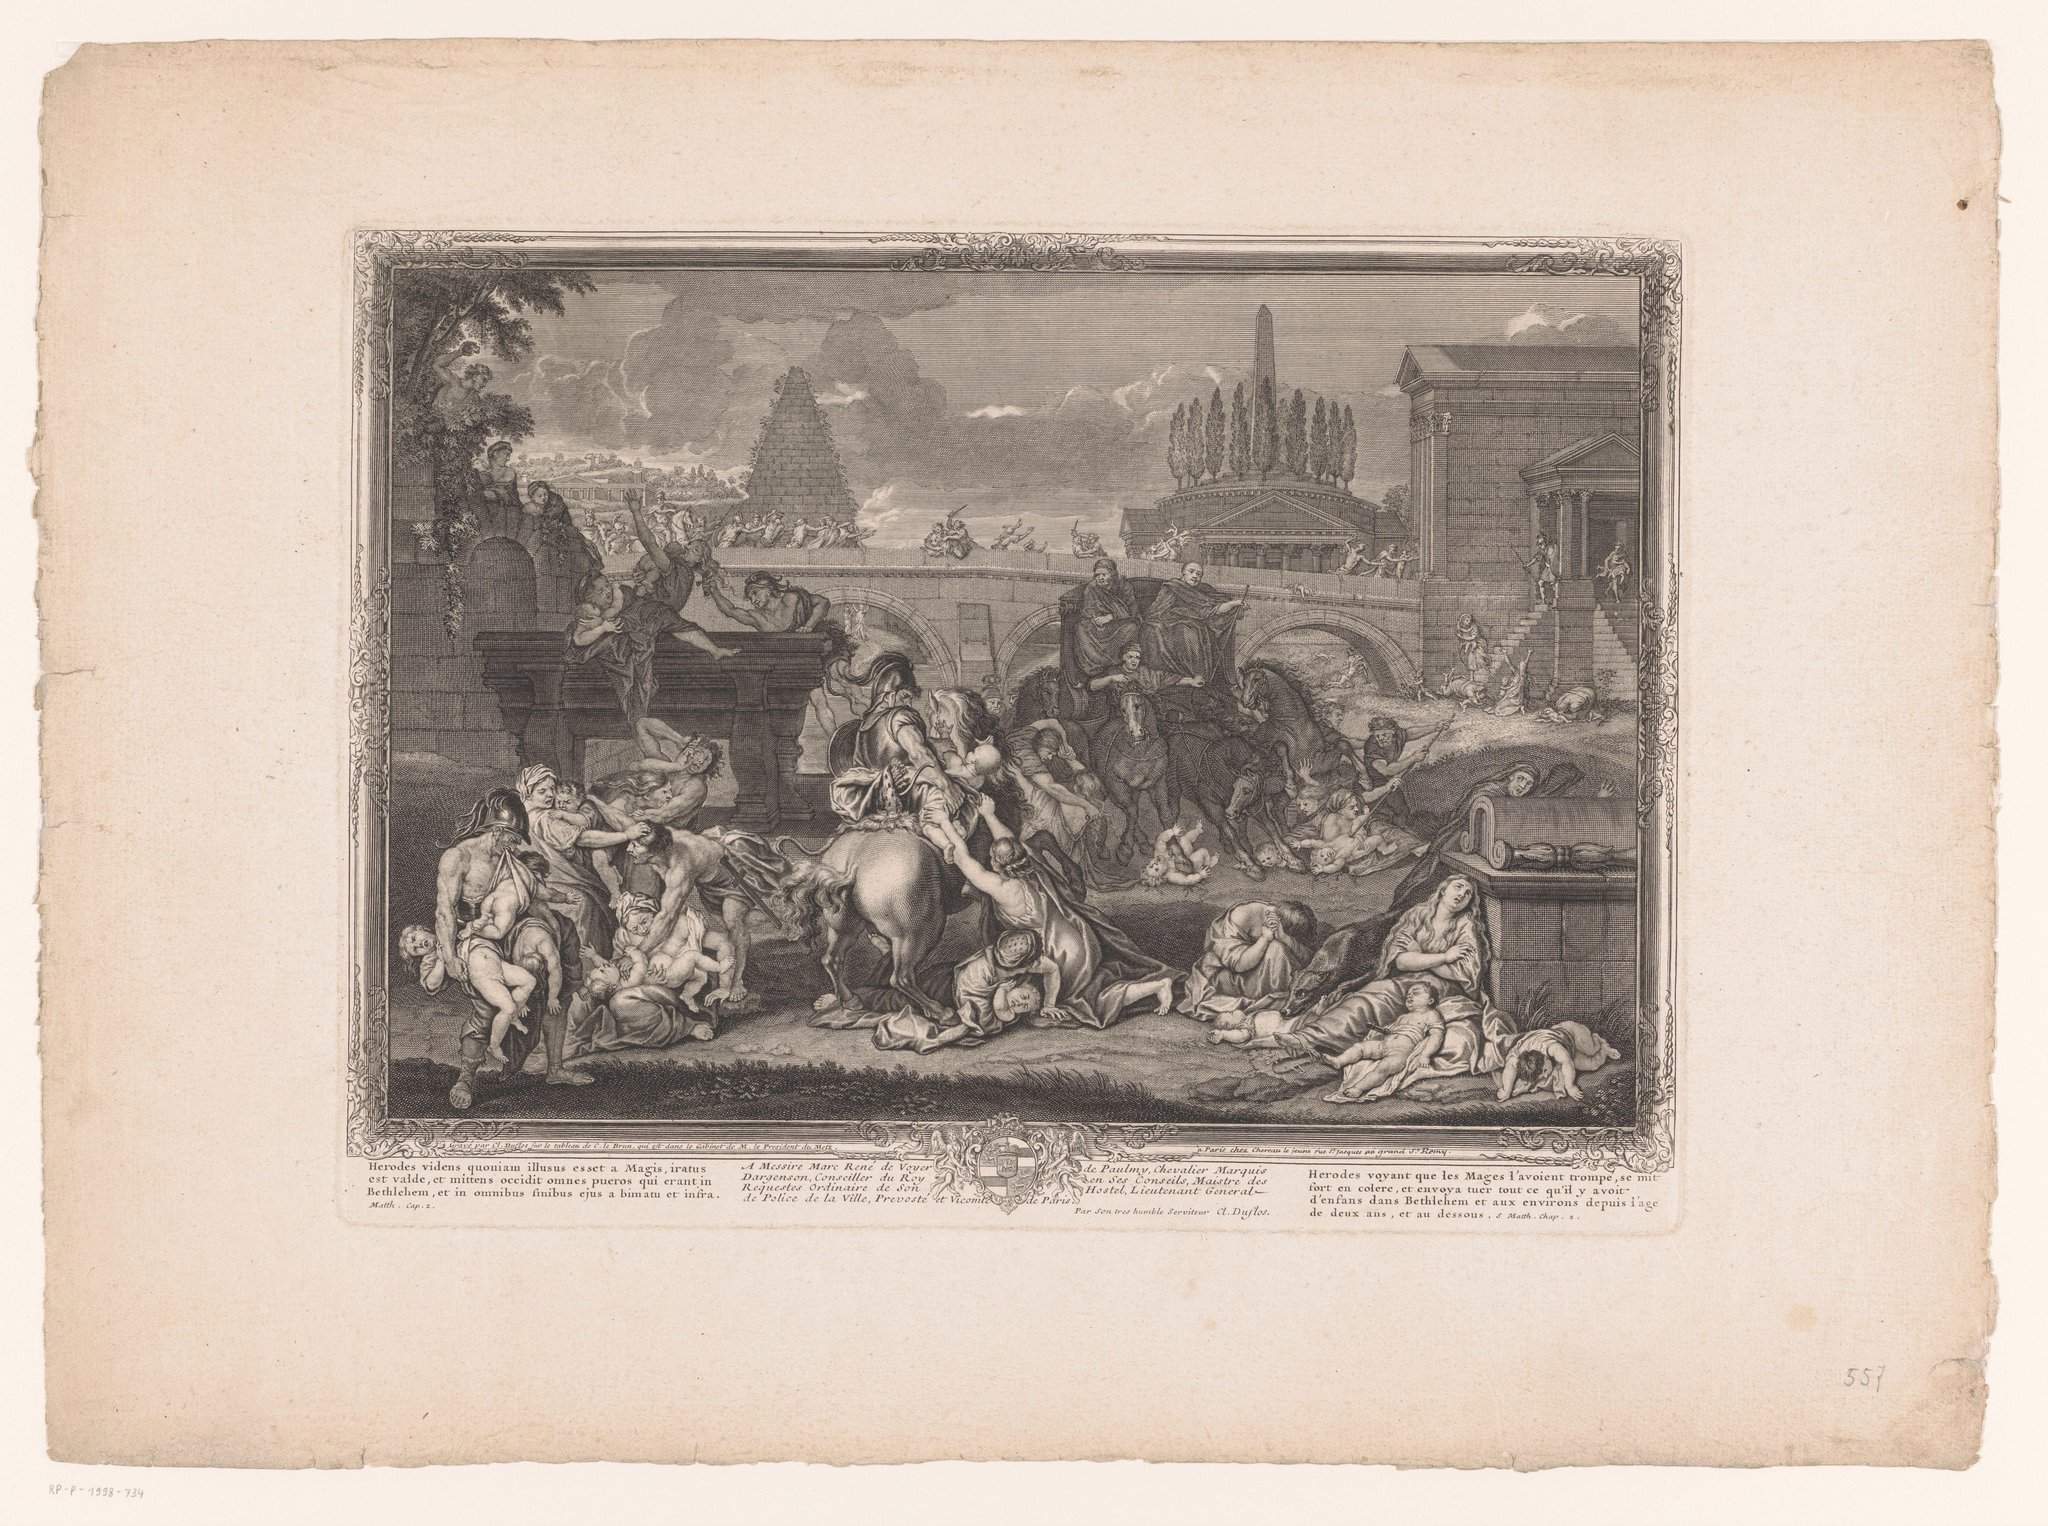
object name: print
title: Kindermoord te Betlehem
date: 1675-1727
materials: paper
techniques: engraving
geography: paris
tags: soldiers entering bethlehem ~ massacre of the innocents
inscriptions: collector's mark: Lugt 2228